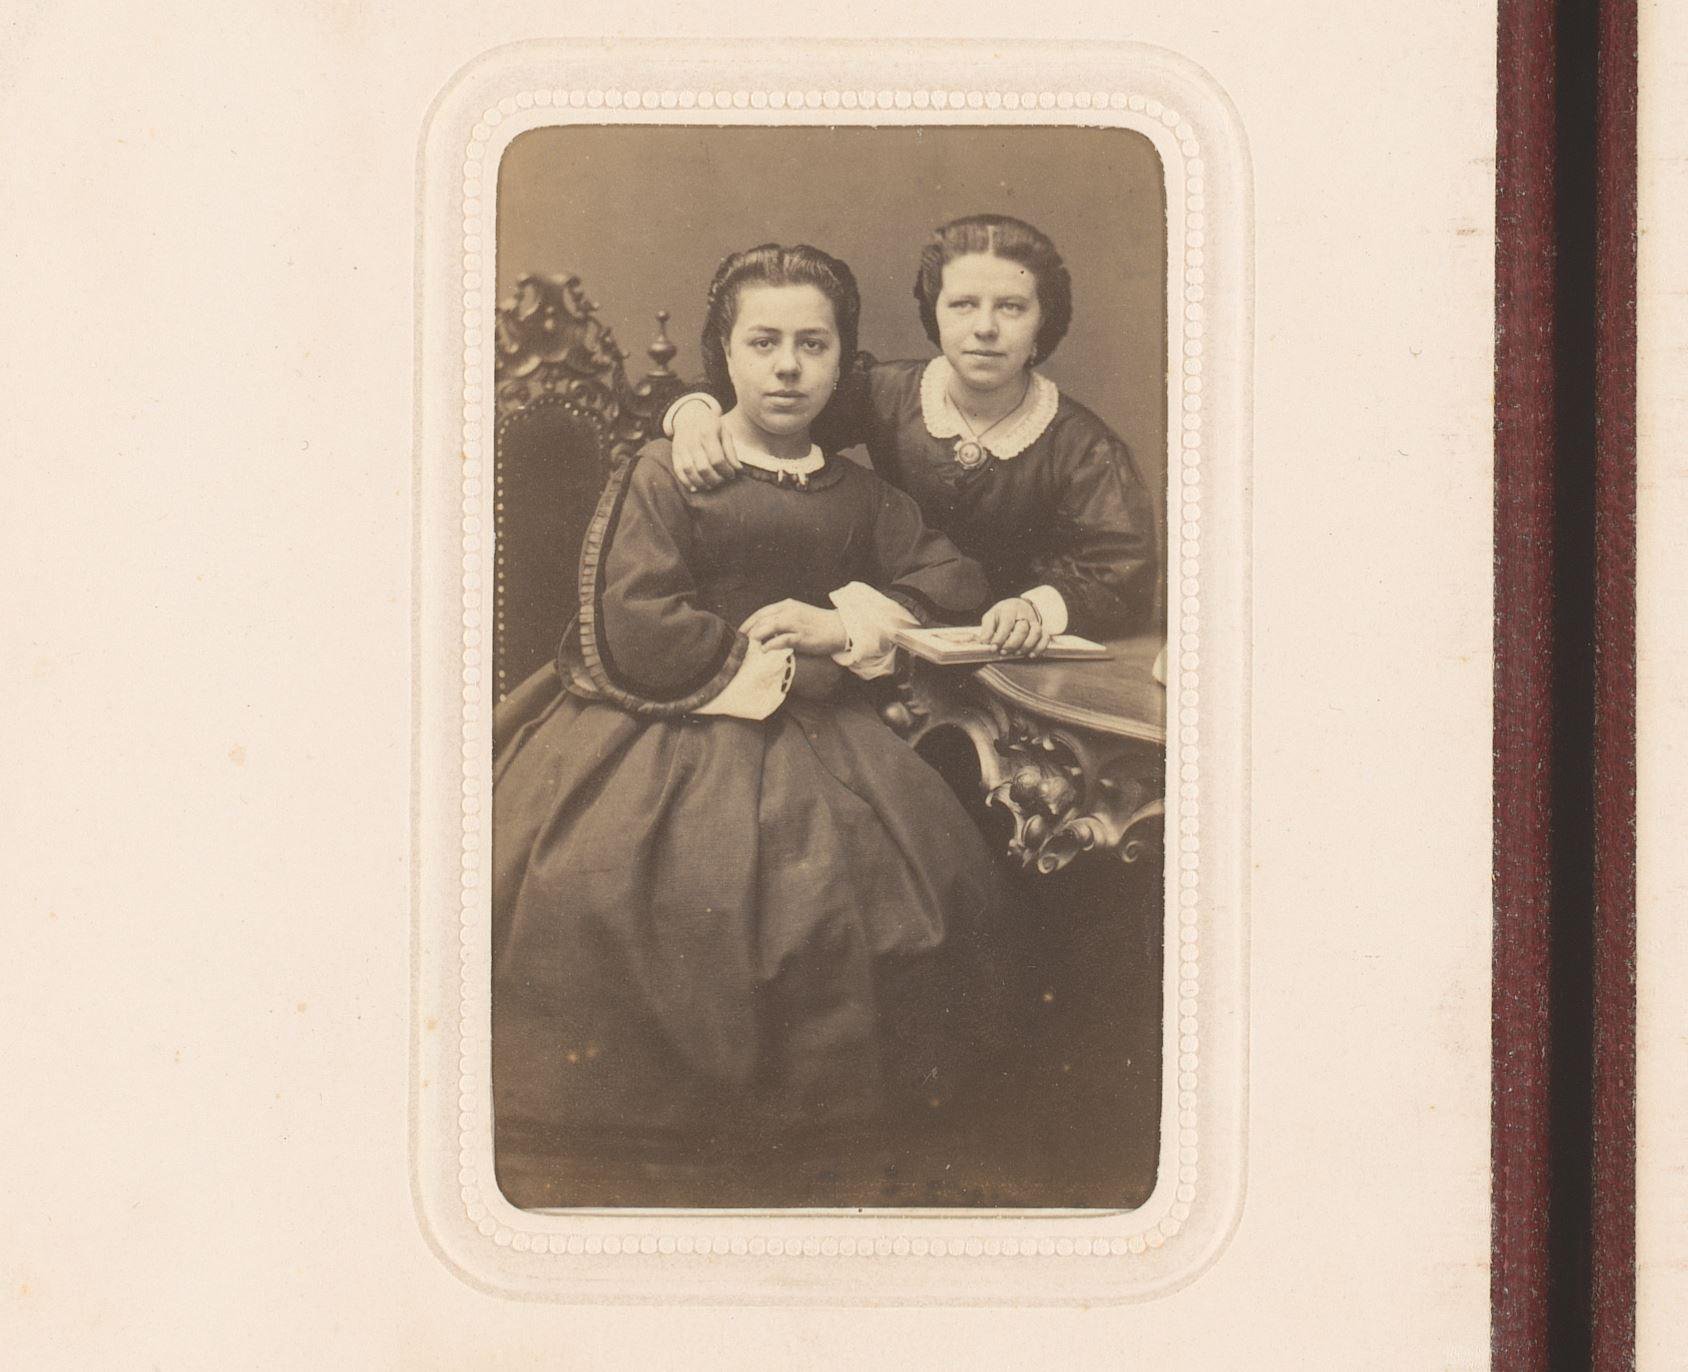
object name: photograph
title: Portret van twee vrouwen, zittend aan een tafel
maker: albert greiner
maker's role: fotograaf, fotostudio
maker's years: 1833-1890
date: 1861-1874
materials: cardboard, paper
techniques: albumen print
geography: amsterdam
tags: sitting figure - aa - female human figure, historical persons - bb - woman, table, adult woman (+ two persons)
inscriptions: inscription: ‘Nieuwendijk L87, Amsterdam’